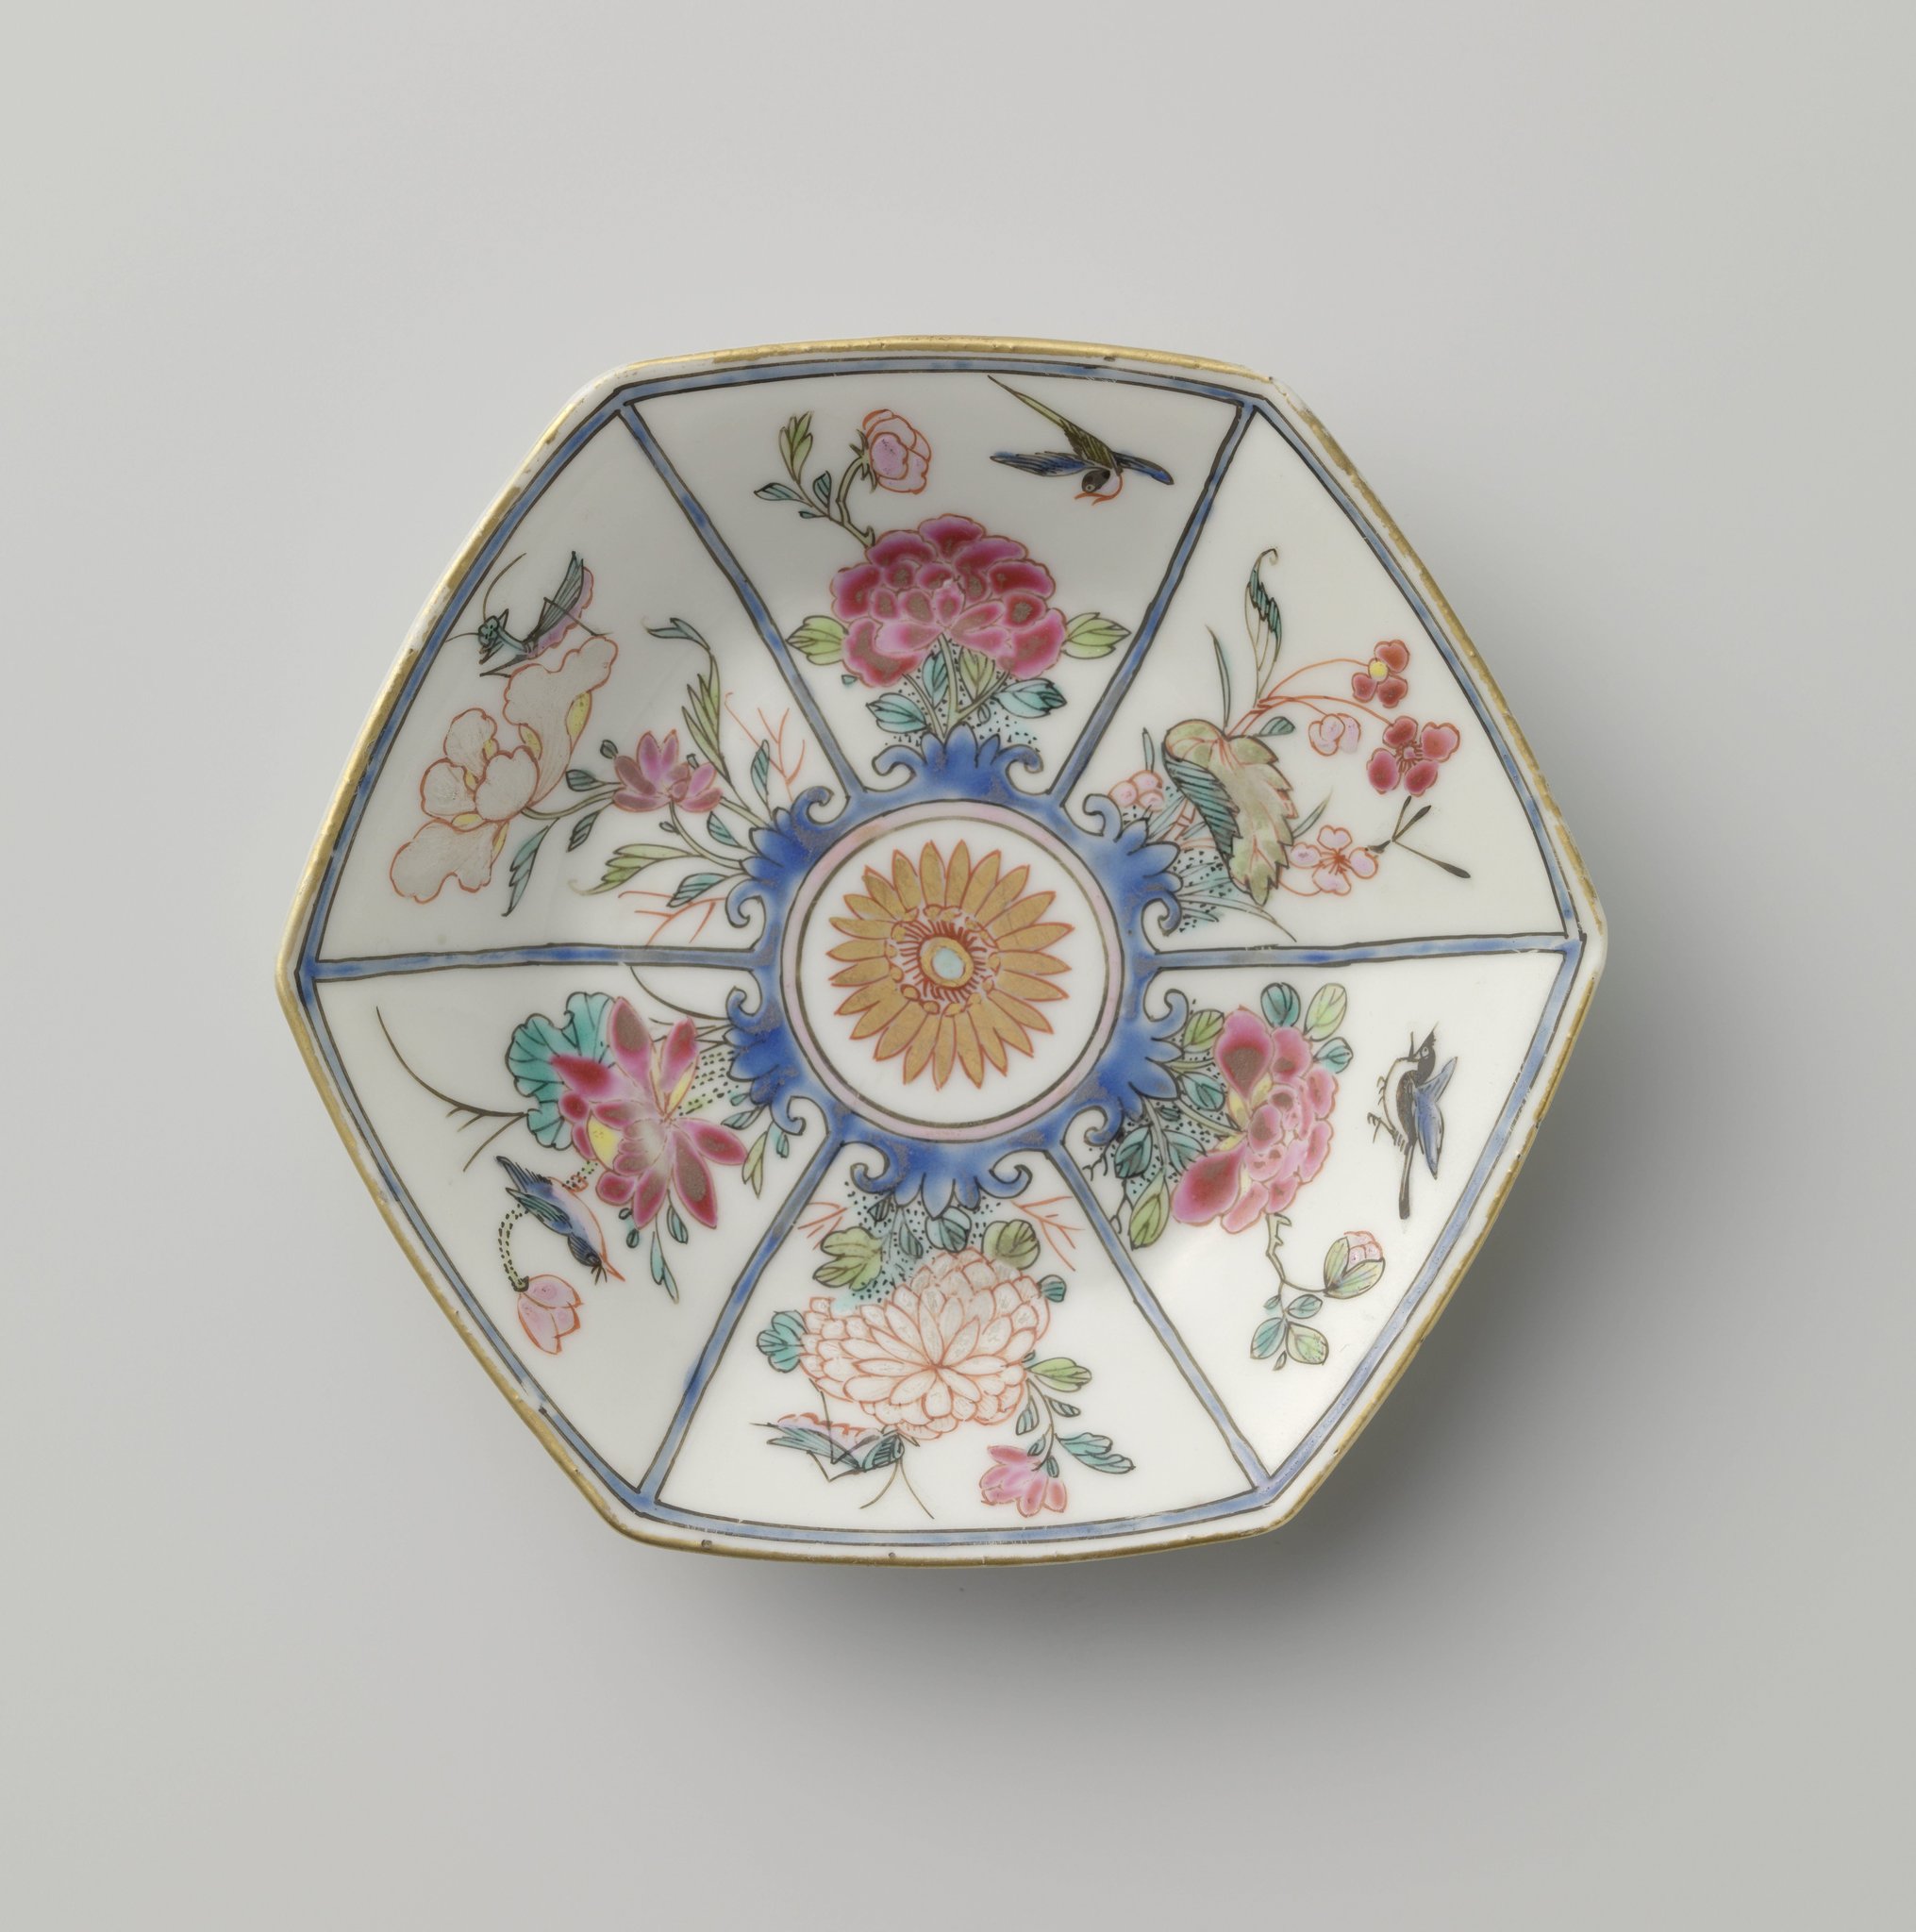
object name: kop en schotel, kop en schotel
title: Saucer with flower sprays, birds and insects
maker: Anonymous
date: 1725-1749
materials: glaze, gold, paint, porcelain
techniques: firing, forming, gilding, turning, vitrification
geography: china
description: Kop en schotel, achtkantig versierd in vakken met vogels en bloemen in famille rose kleuren.